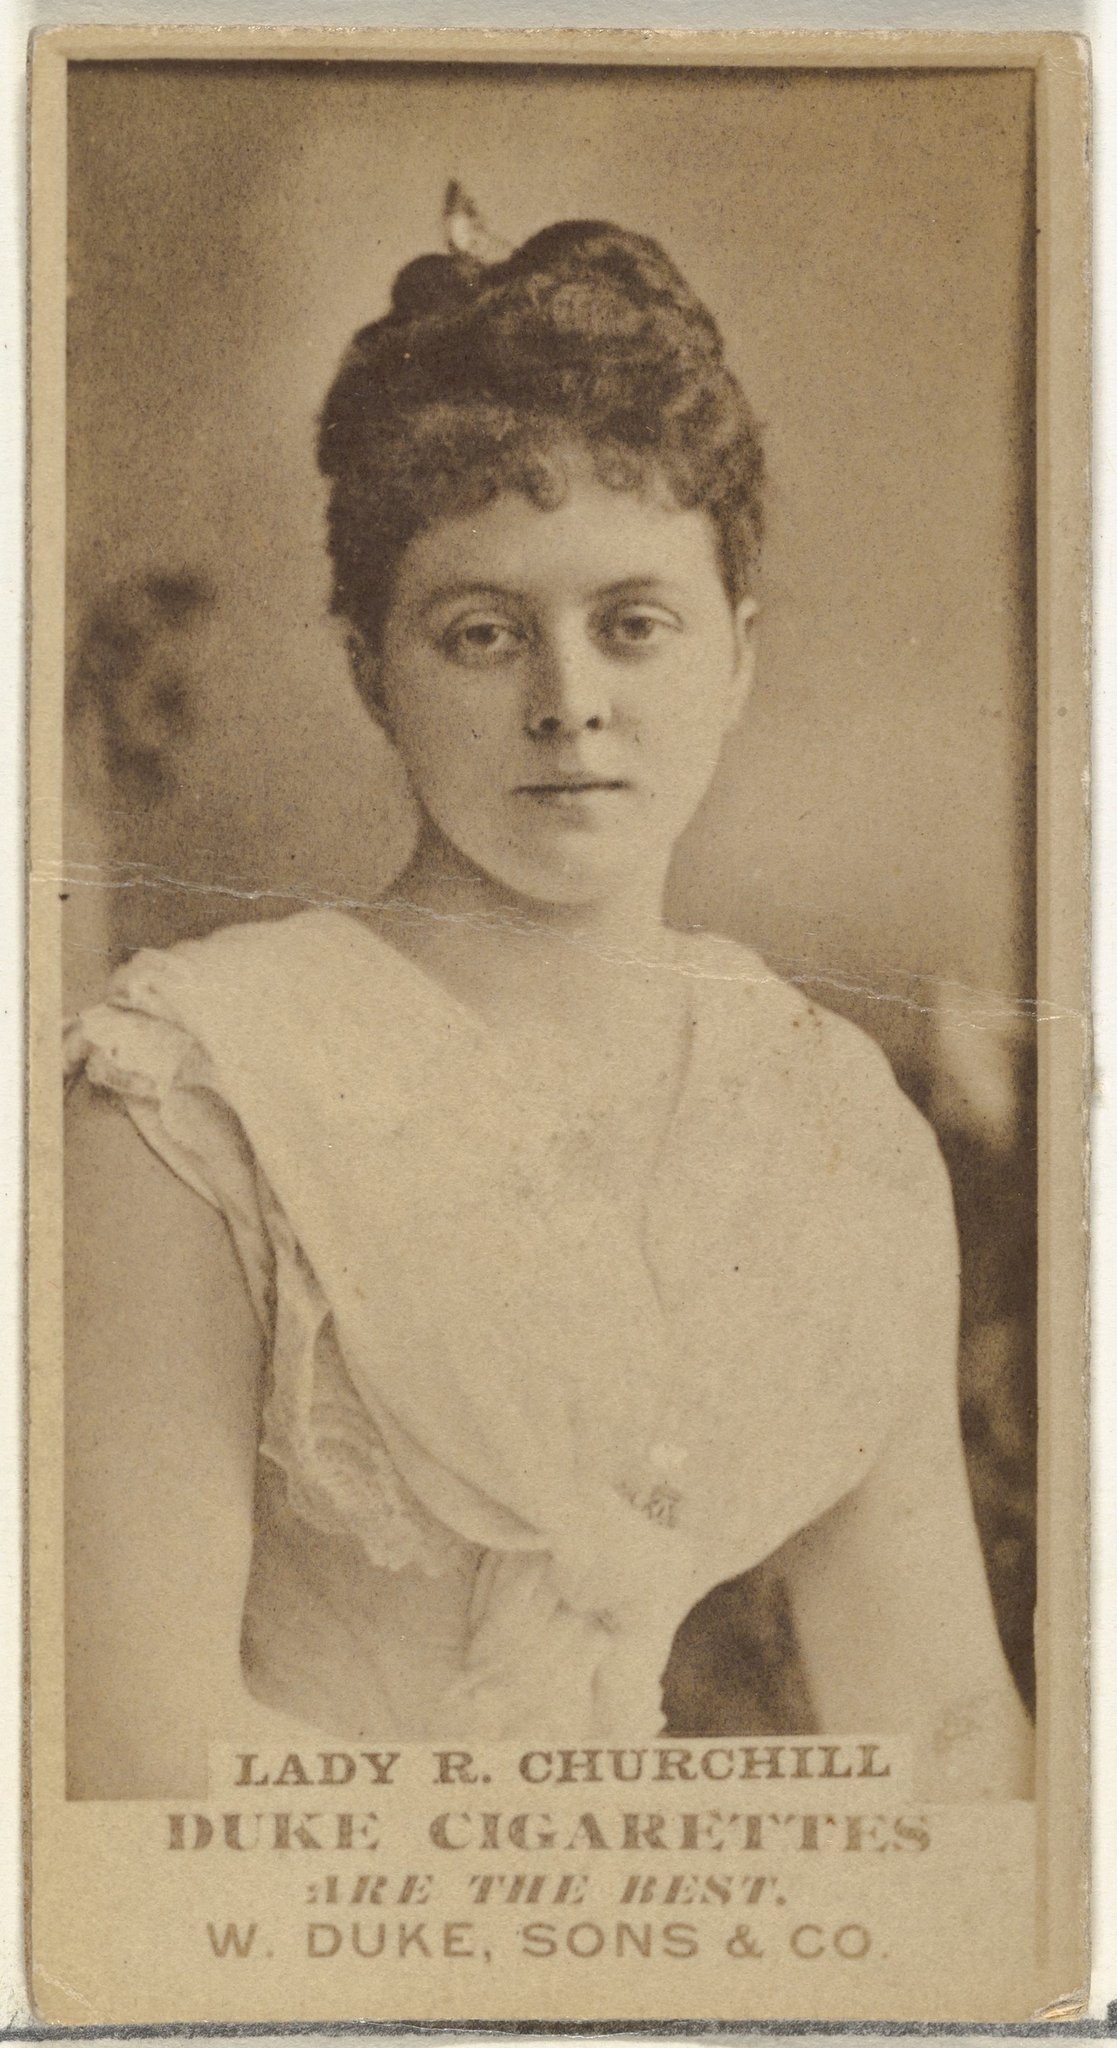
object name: photograph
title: Lady R. Churchill, from the Actors and Actresses series (N145-7) issued by Duke Sons & Co. to promote Duke Cigarettes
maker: w. duke, sons & co.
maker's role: publisher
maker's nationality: american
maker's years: 1870-1920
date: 1880-1889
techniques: albumen silver print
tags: portraits,women,actresses